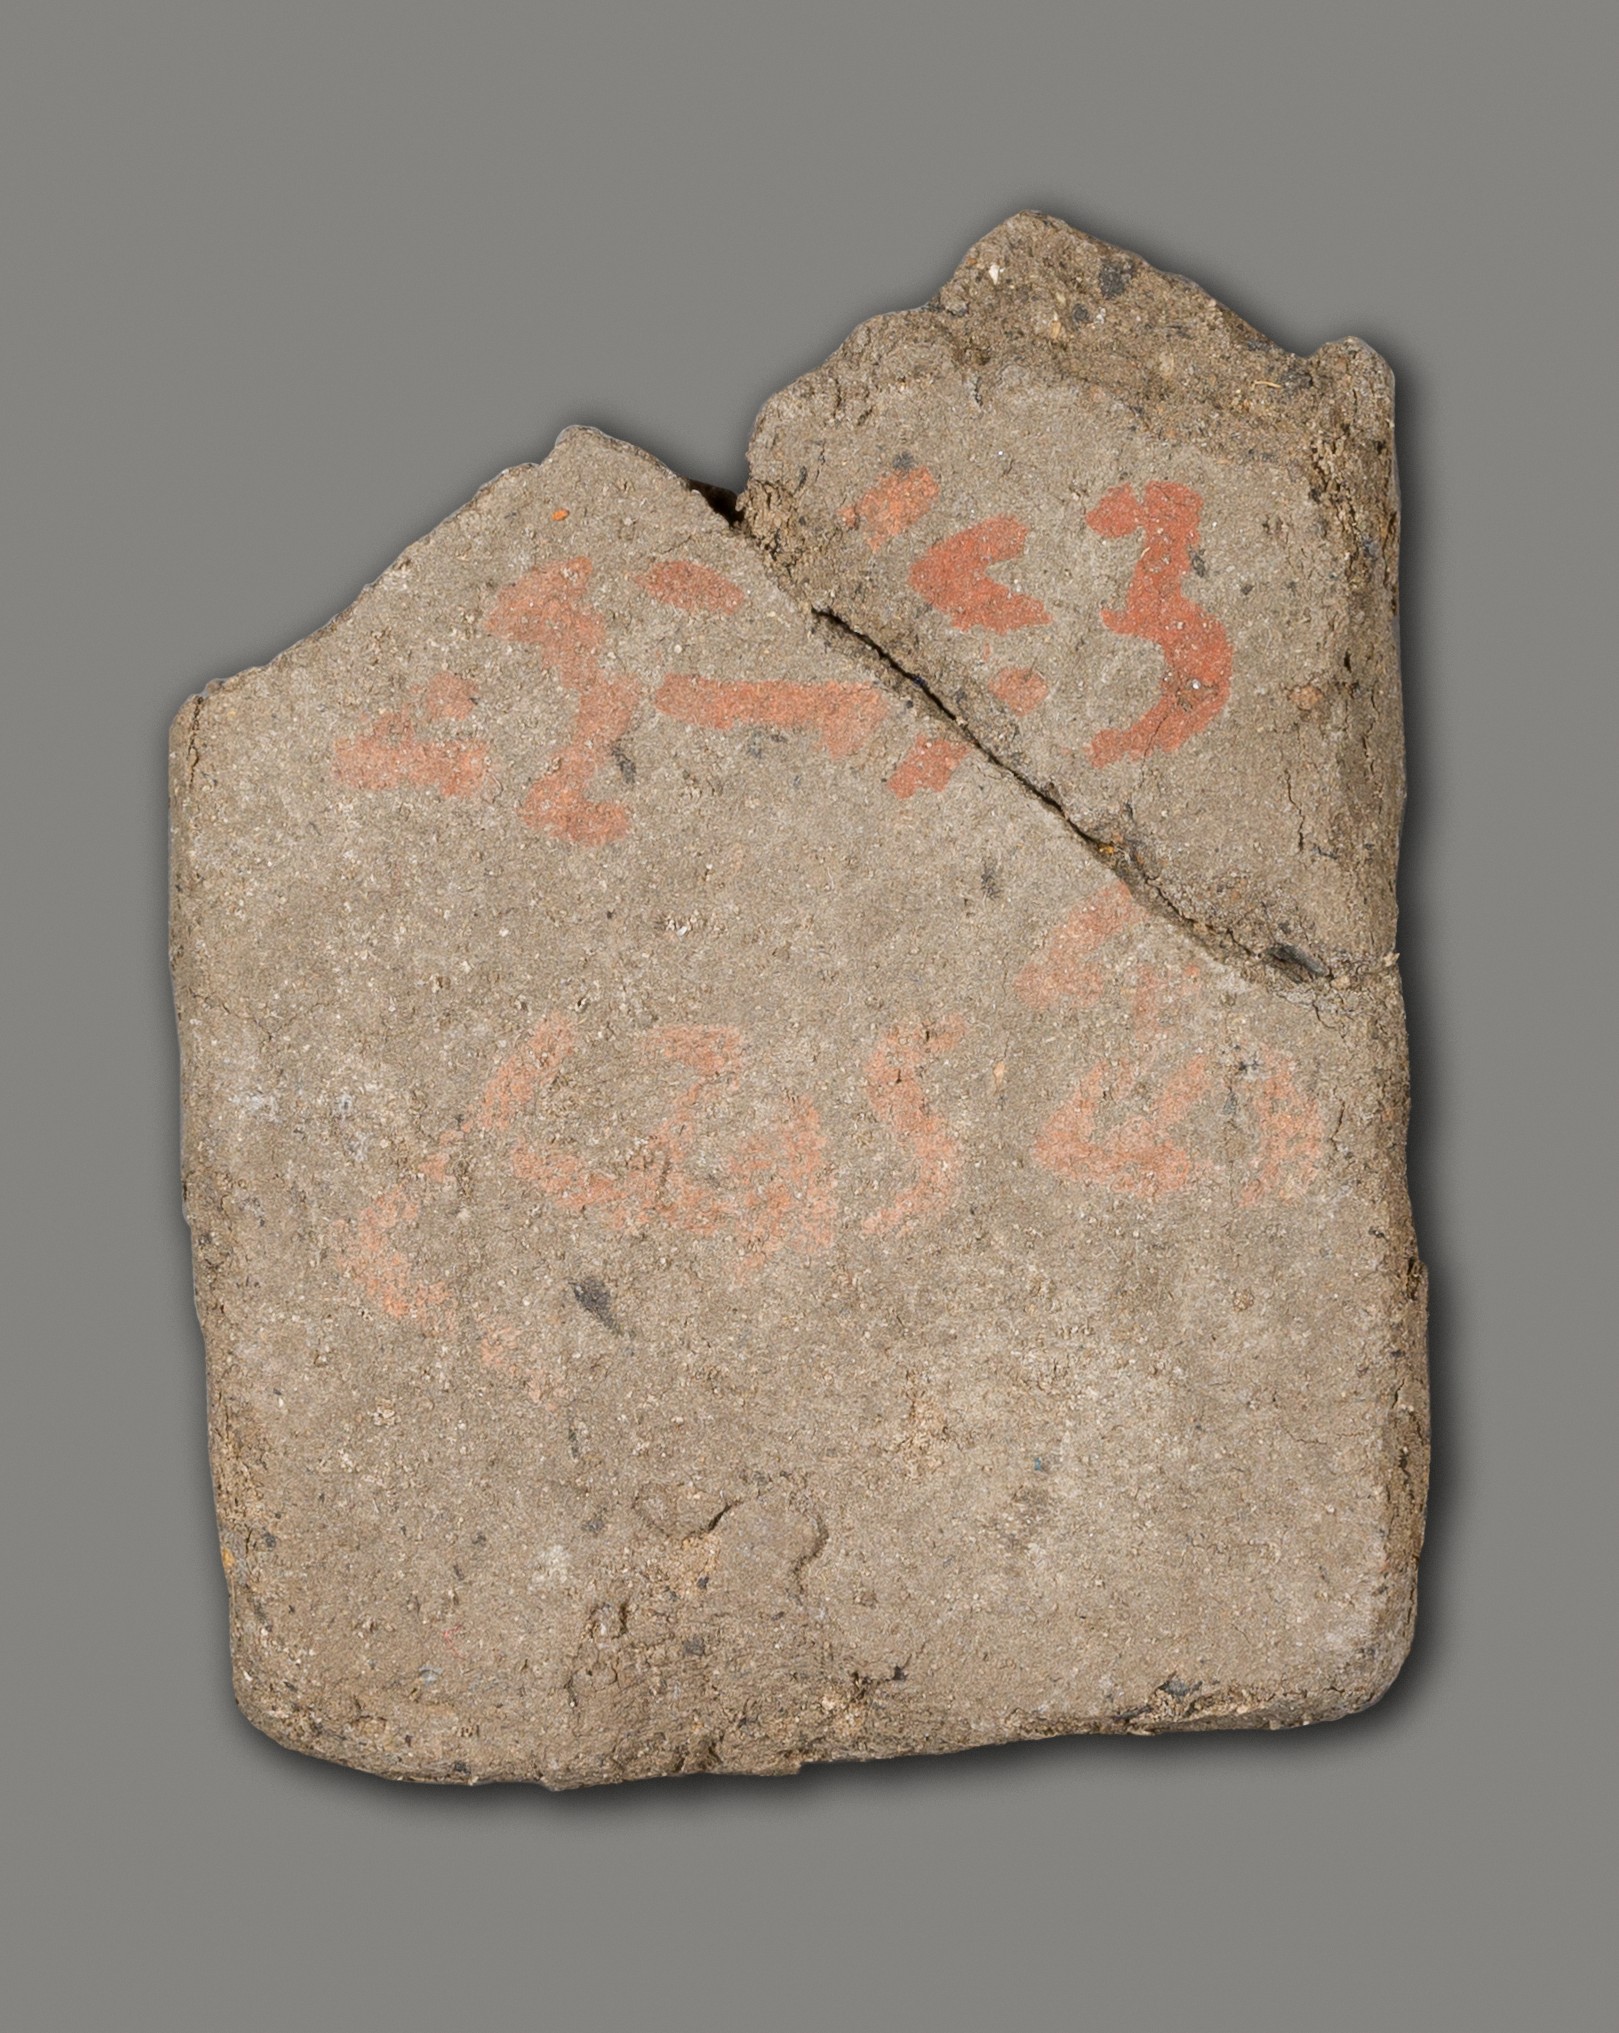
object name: figure, magical, execration, tablet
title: Magical Figure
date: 1802-1550 BCE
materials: clay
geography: egypt